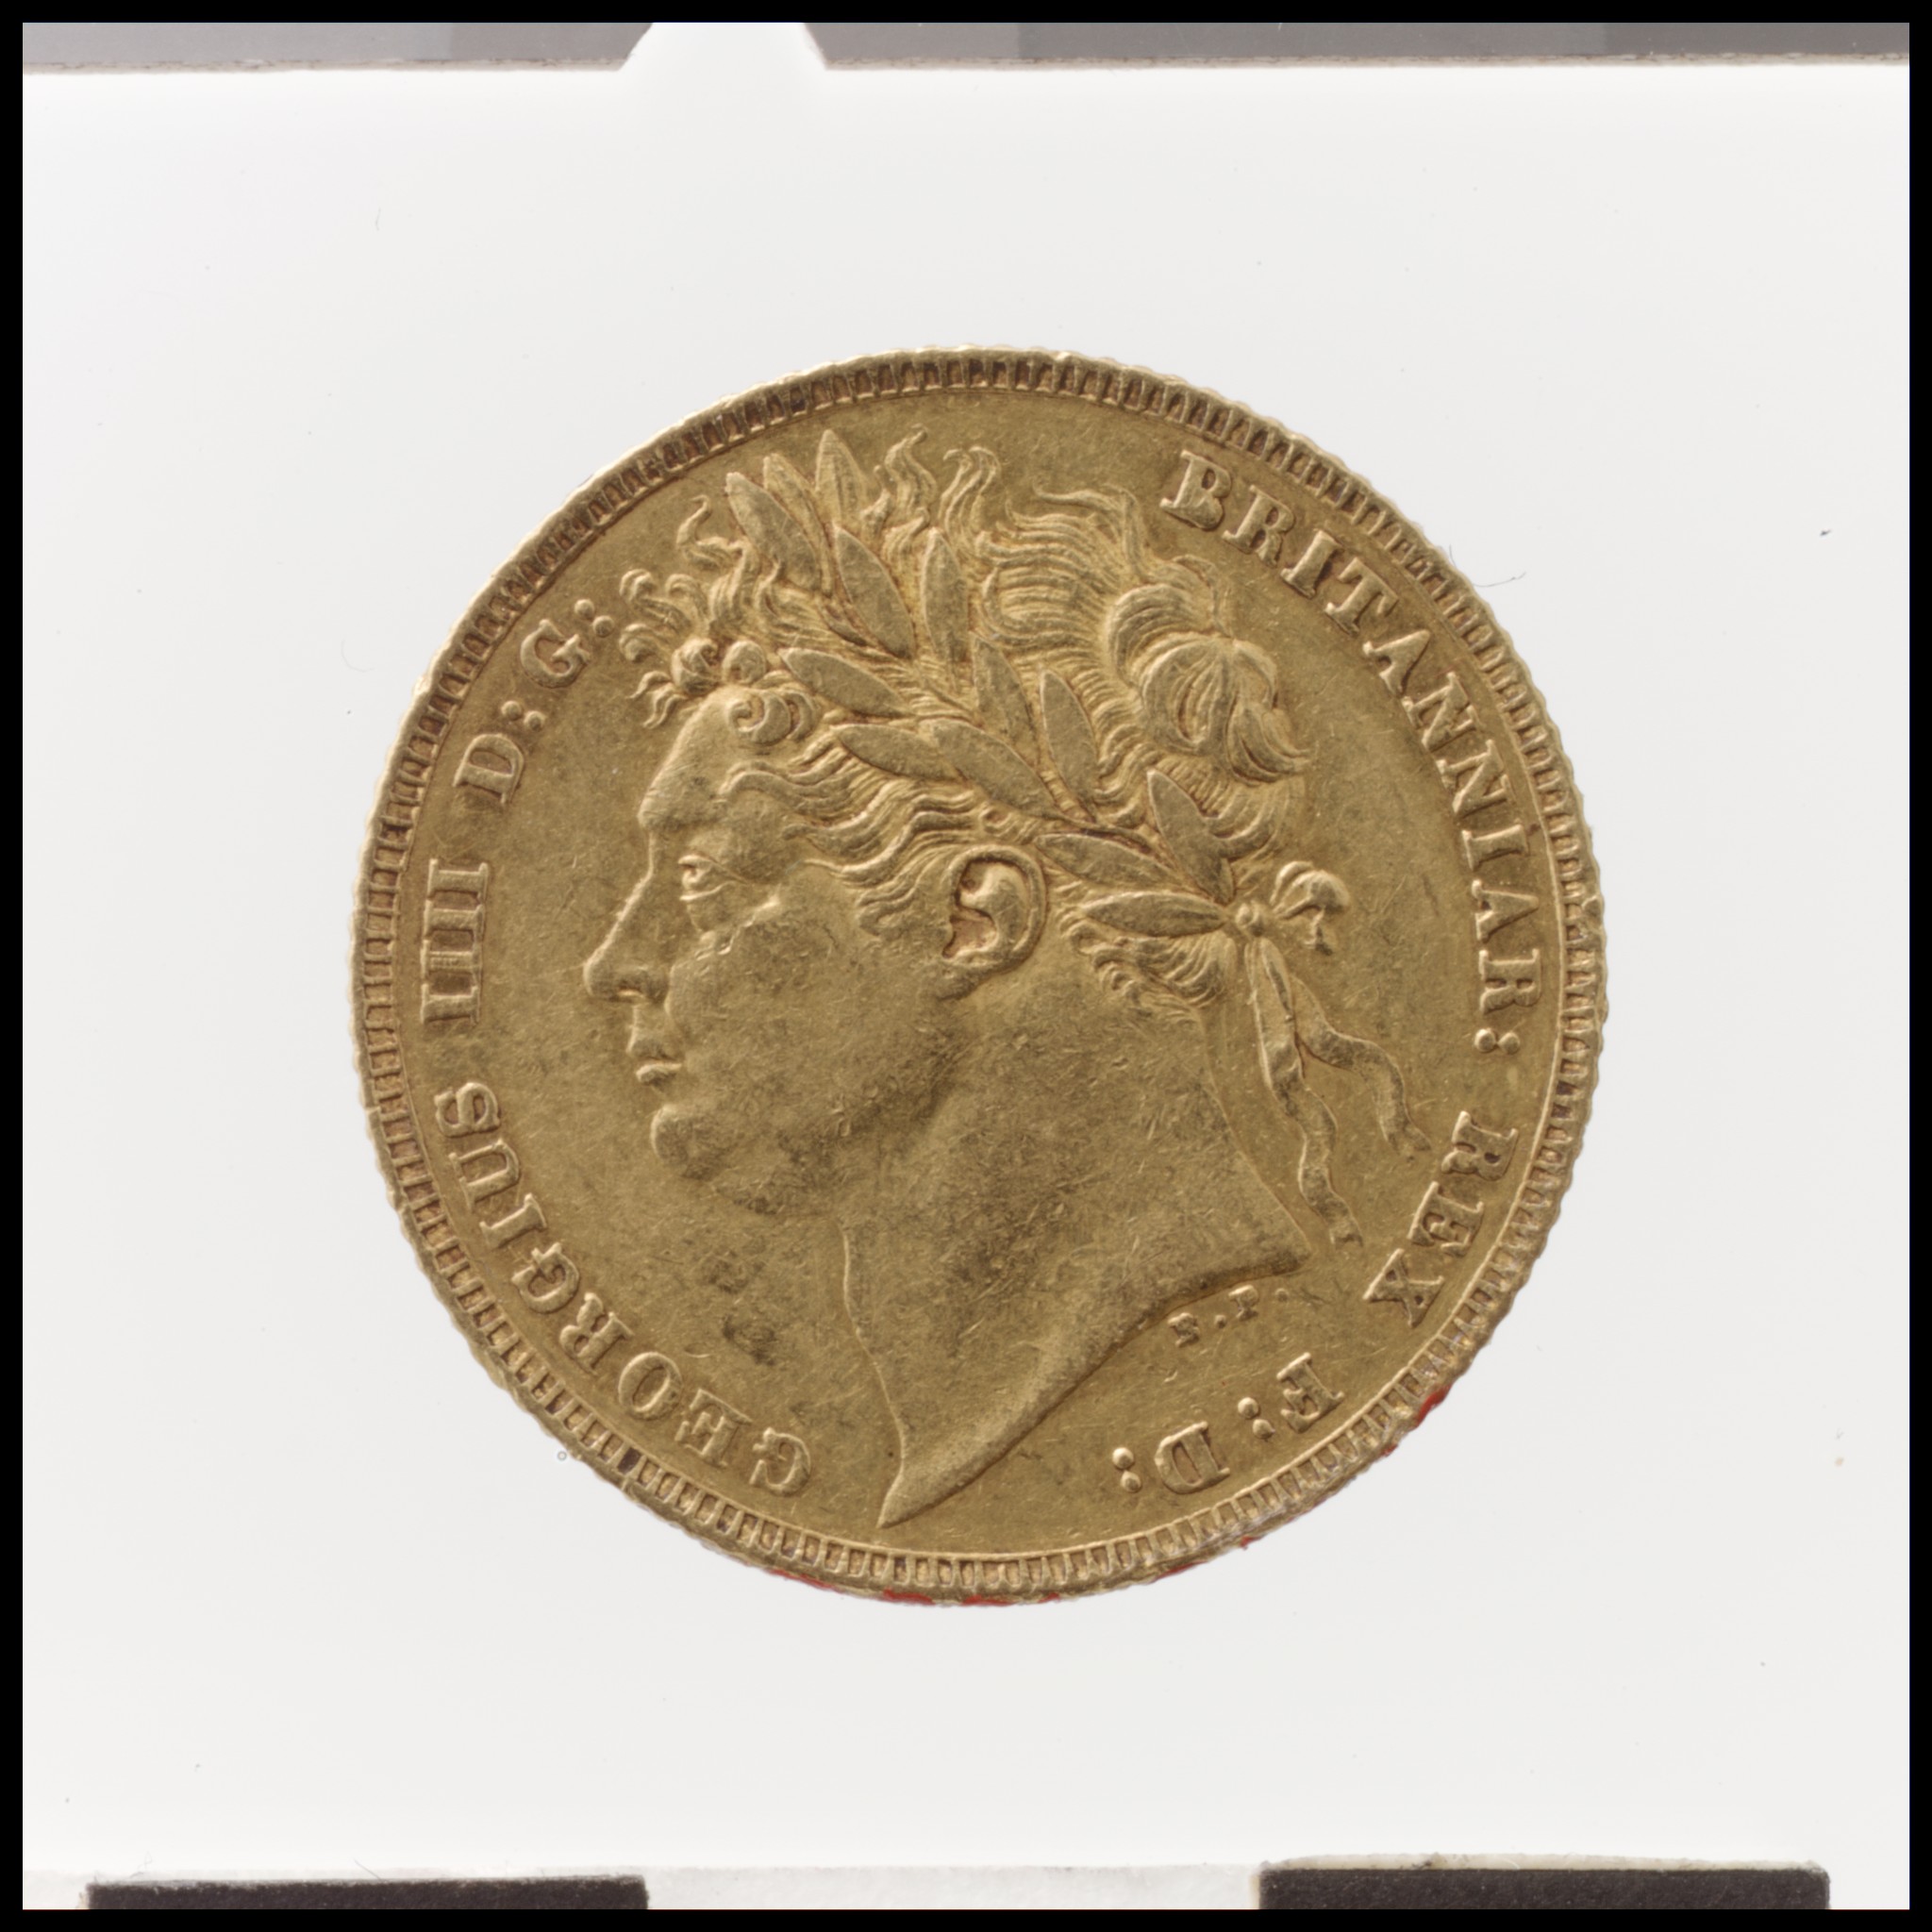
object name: sovereign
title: George IV sovereign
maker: benedetto pistrucci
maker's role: maker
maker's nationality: italian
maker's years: 1783-1855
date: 1821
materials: gold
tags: kings,profiles,horses